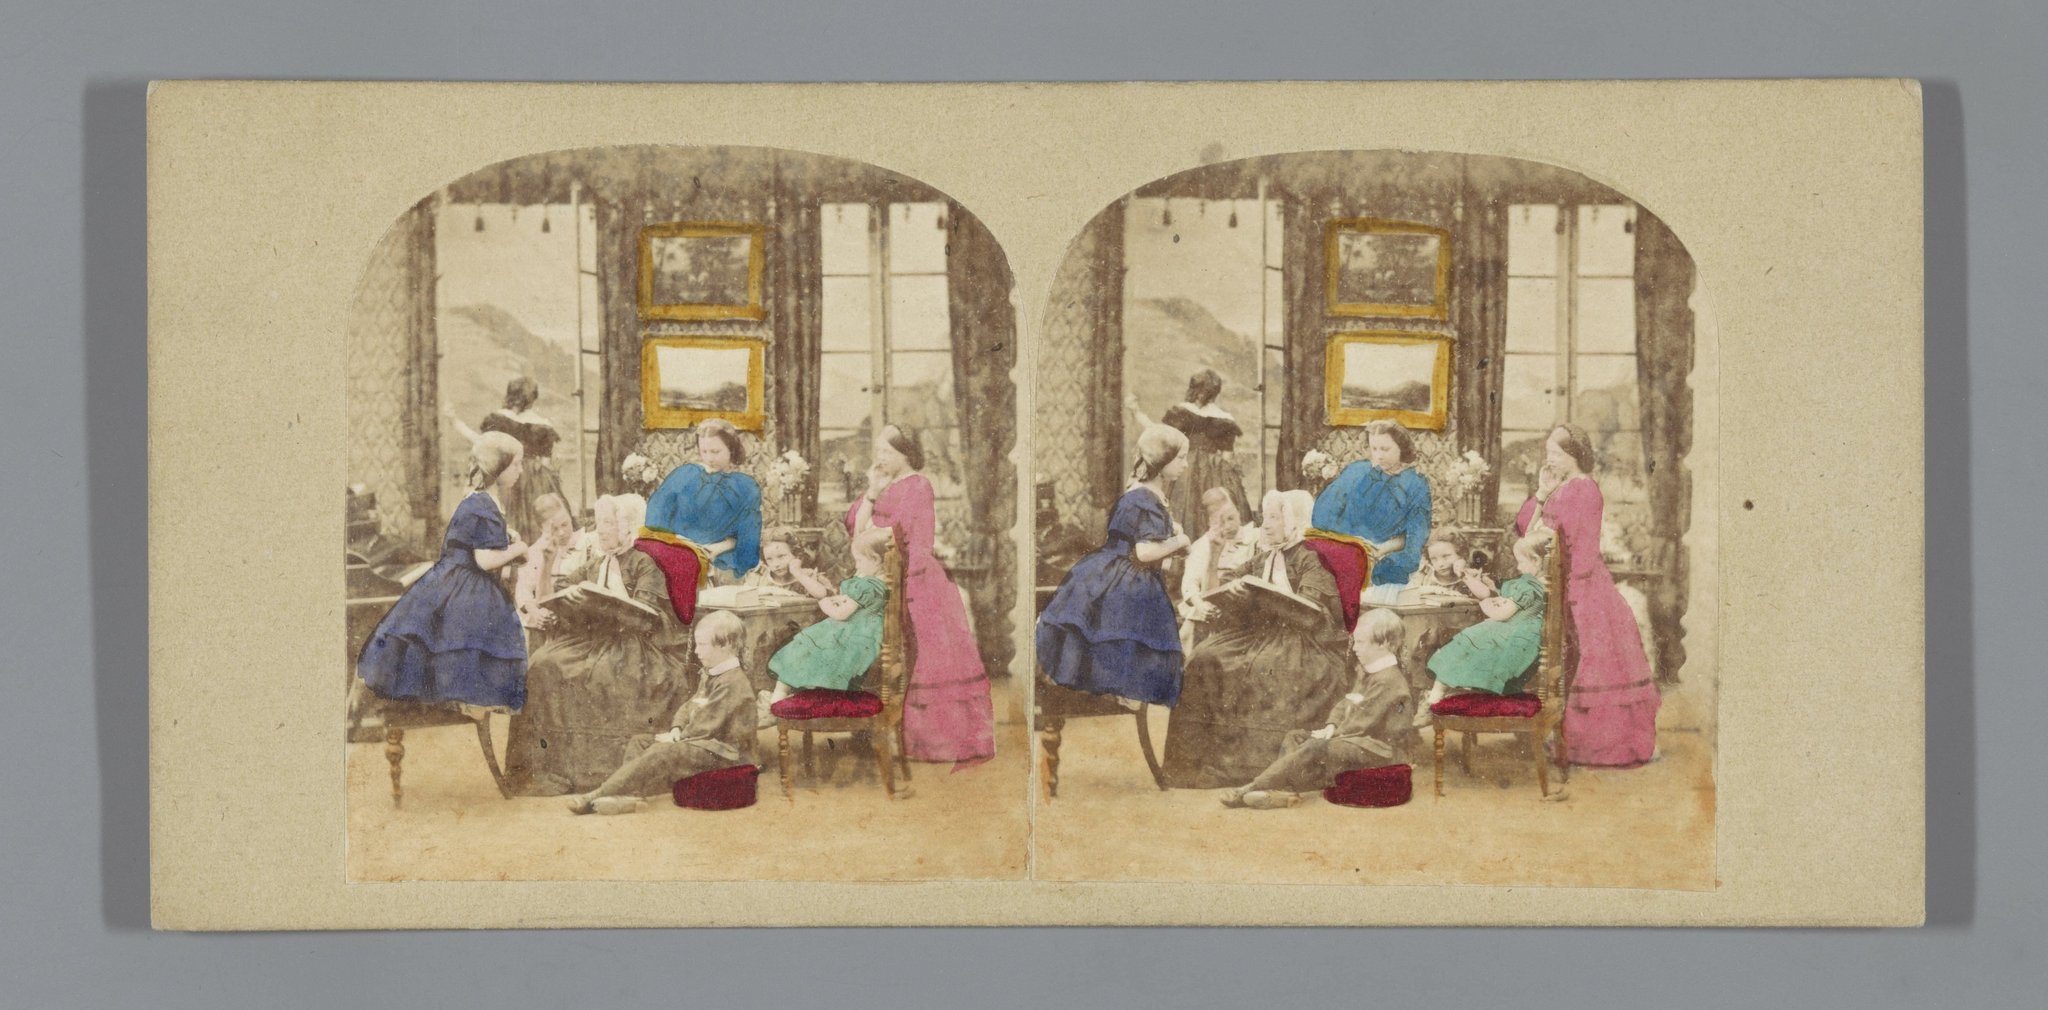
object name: stereograph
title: Oudere vrouw leest voor aan een groep kinderen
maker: Anonymous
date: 1852-1863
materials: cardboard, paper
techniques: albumen print, hand coloring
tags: family life, reading to somebody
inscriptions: inscription: ‘nr. 7./ e "-"’